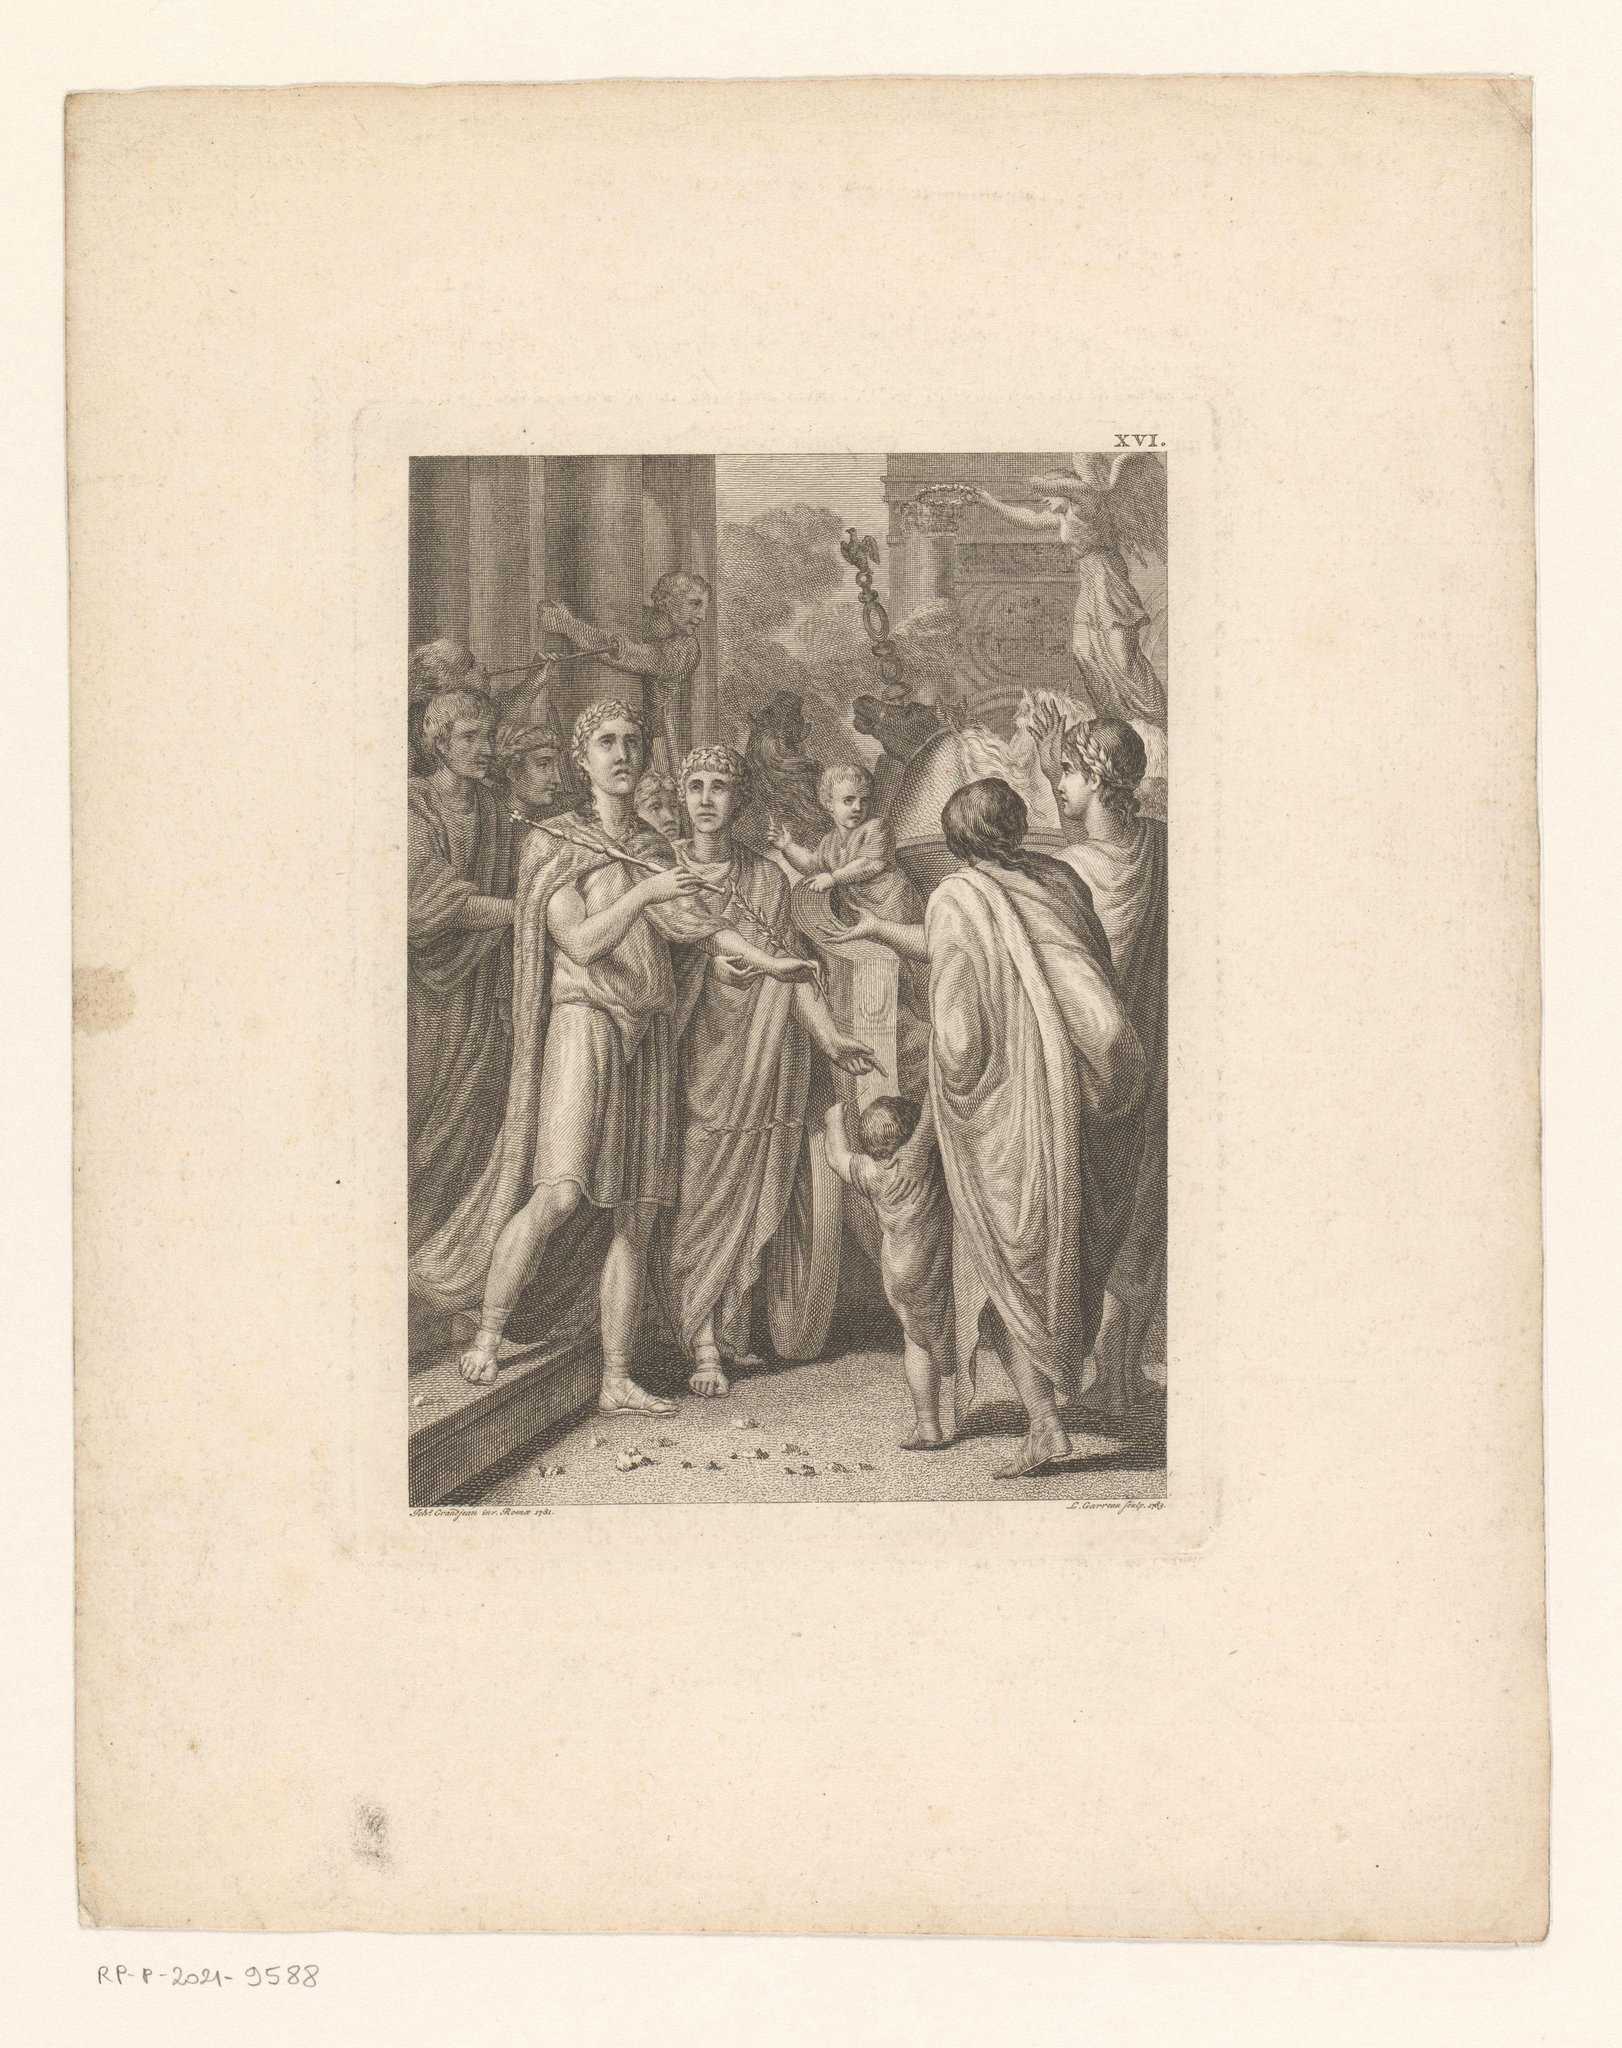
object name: print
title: Geschiedenis van Germanicus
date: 1783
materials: paper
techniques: engraving, etching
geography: france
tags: conqueror triumphing, triumphal entry of victor, (story of) germanicus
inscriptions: date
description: Volgens Muller werden de prenten uit deze serie door verschillende prentmakers in 1783 gemaakt naar de kleine schilderijen van Grandjean te Rome, en in 1788 uitgegeven. De prent wordt ook ingebonden gevonden in: Winter, Lucretia Wilhelmina van. Germanicus in Zestien Boeken. Amsterdam: Pieter Meijer, 1779.